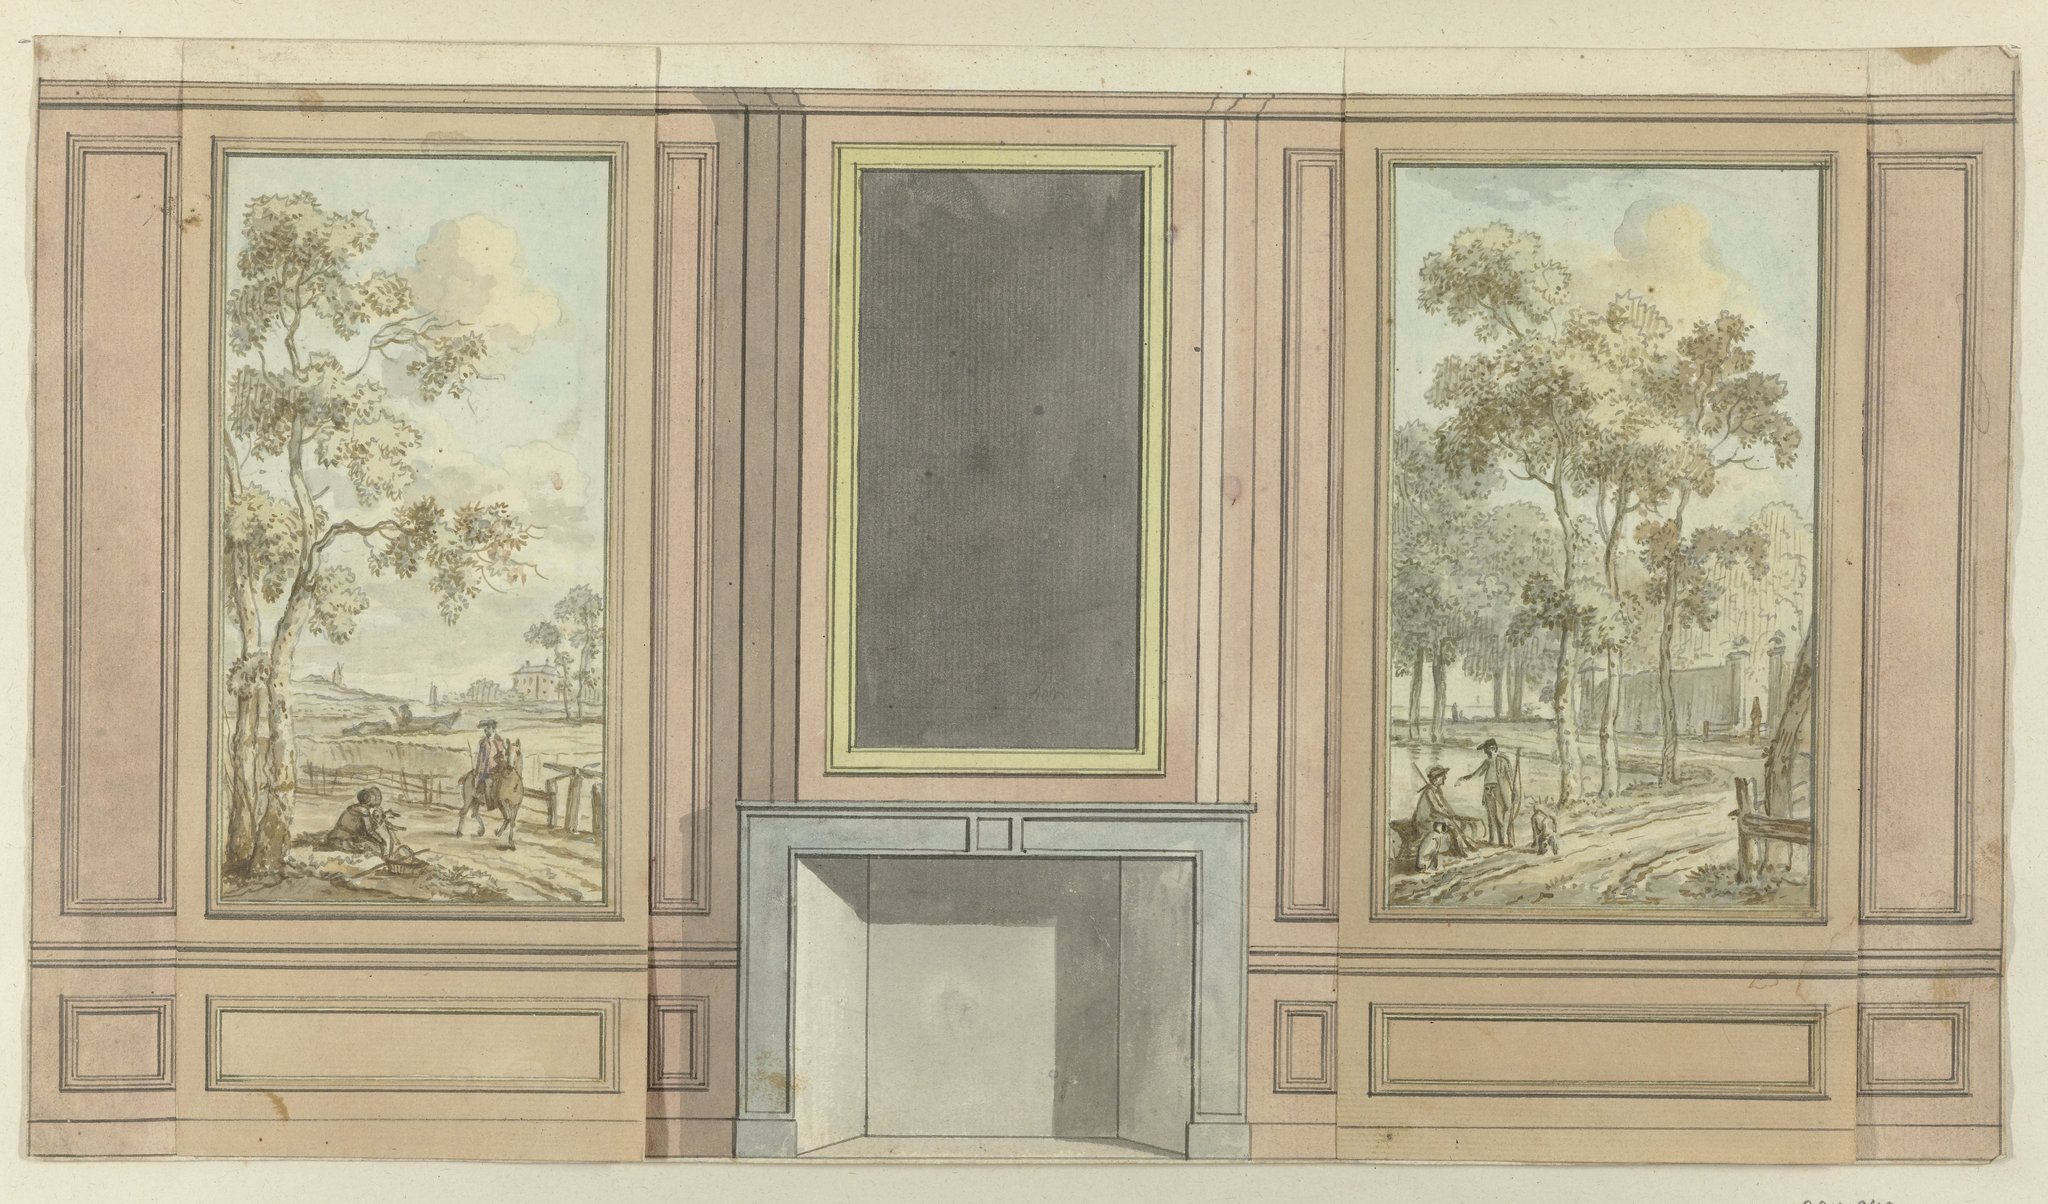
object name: drawing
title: Ontwerp voor een wandschildering in de zijkamer bij Hendrik Wessels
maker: jurriaan andriessen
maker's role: draughtsman, painter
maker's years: 1742-1819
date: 1780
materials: ink, paper, pencil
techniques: brush, pen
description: Wand met twee behangselvakken en twee opzetvellen ter weerszijden van een schoorsteen.